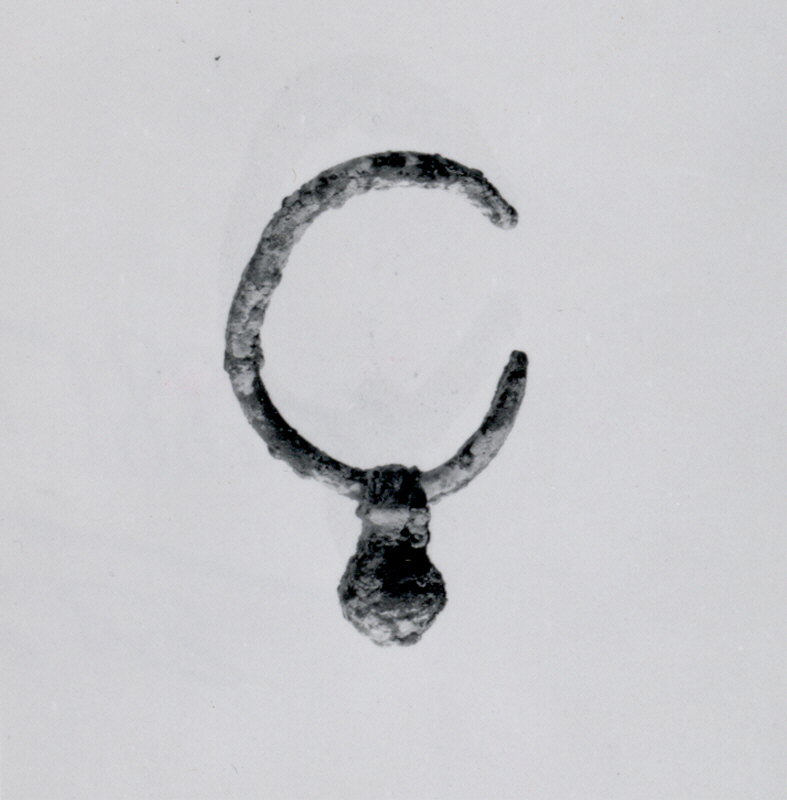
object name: earring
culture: parthian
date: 1-100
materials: bronze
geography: iran